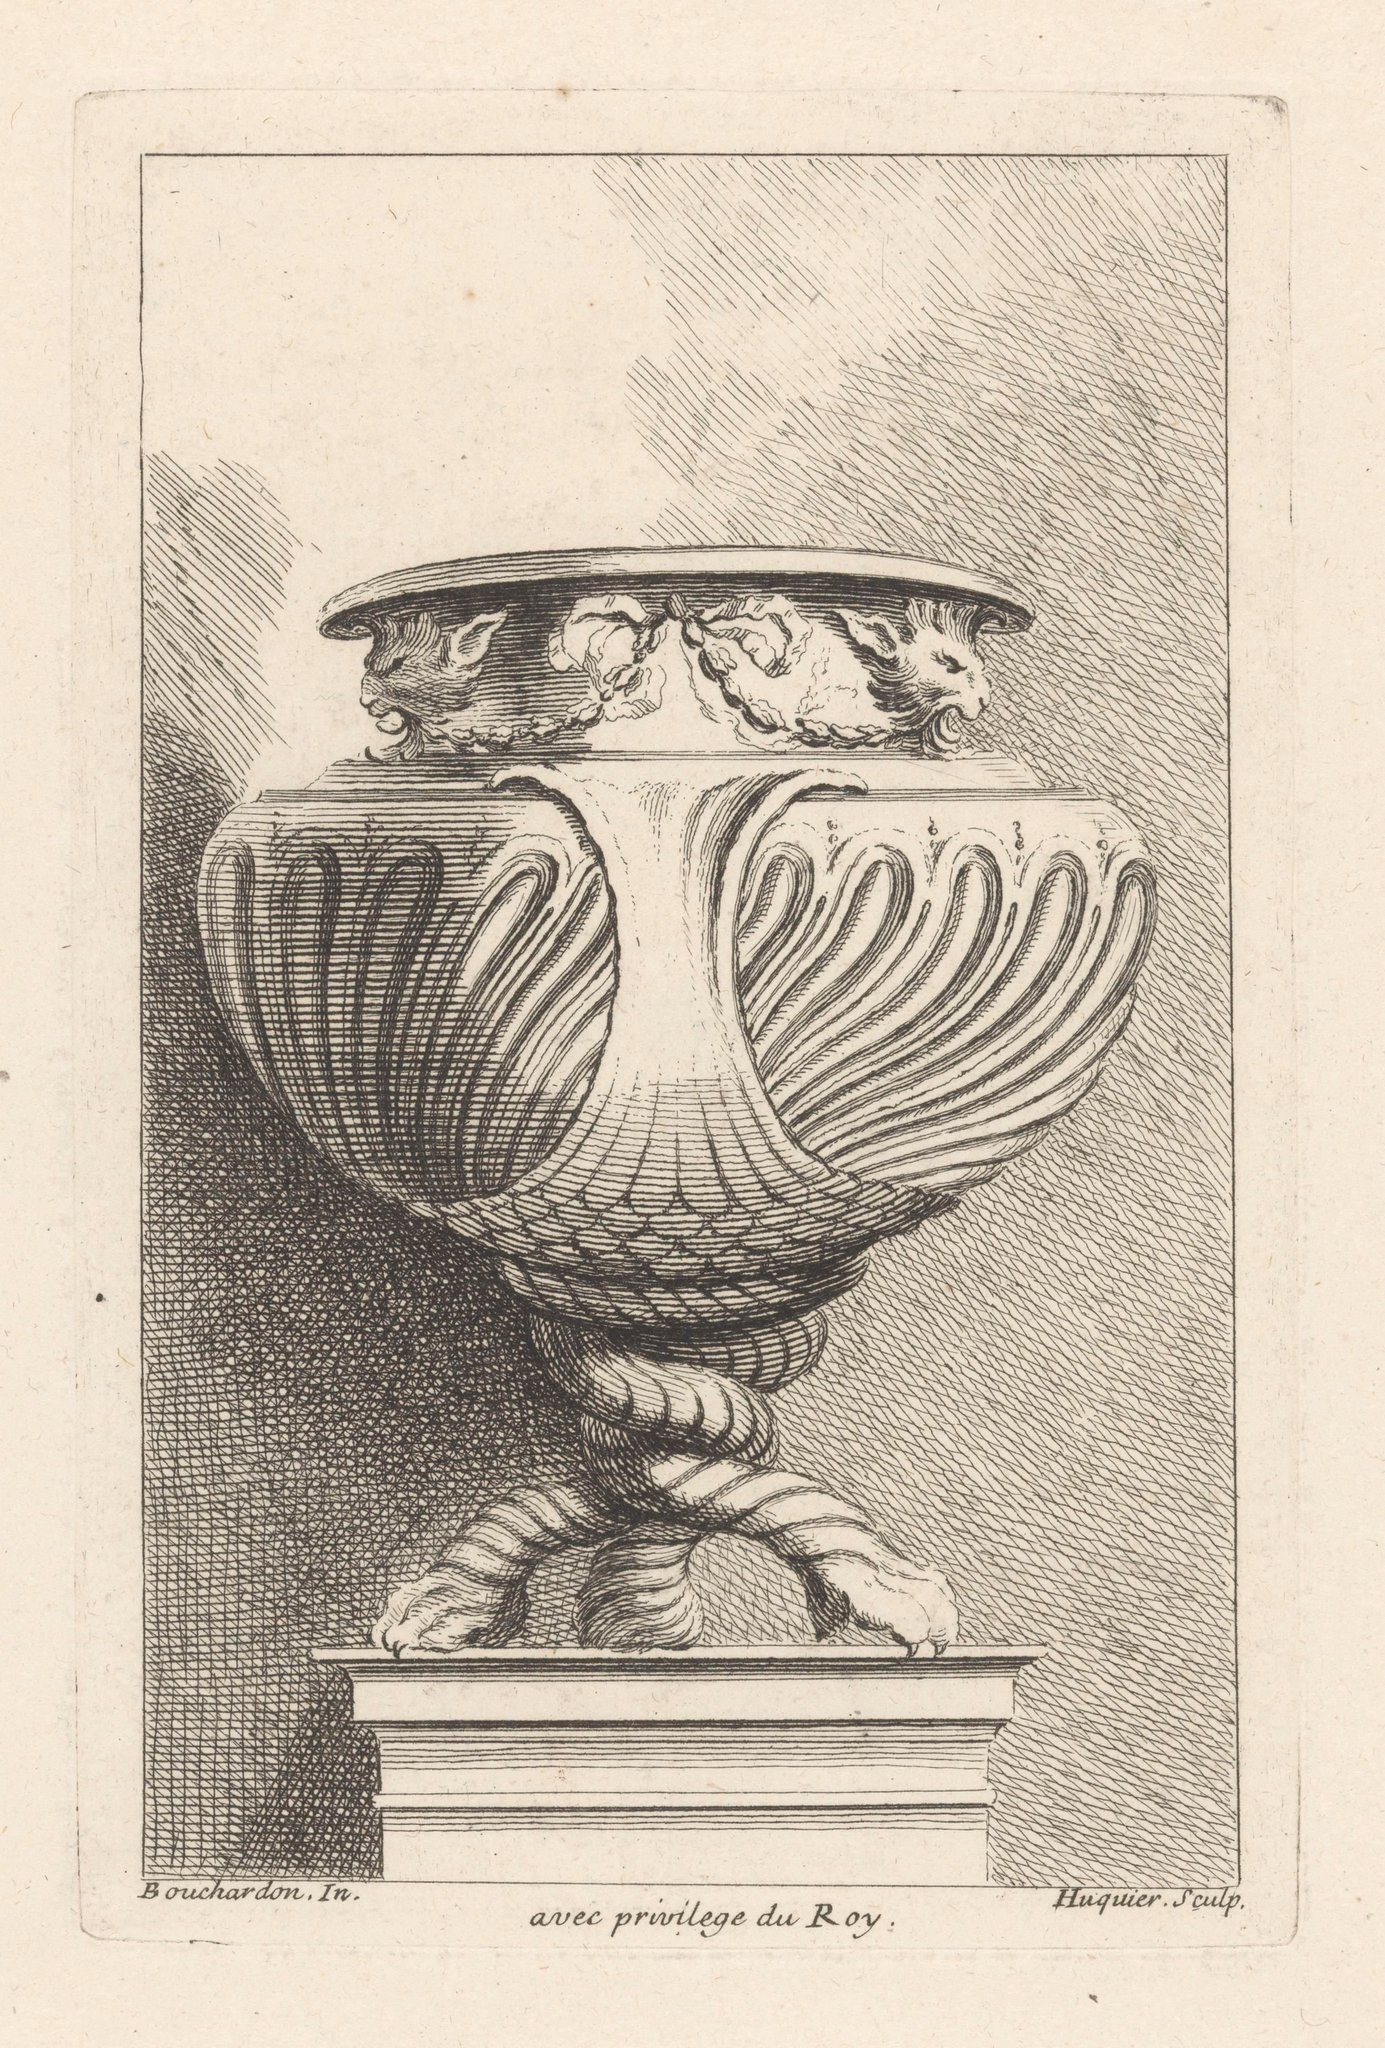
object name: ornament print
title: Premier livre de vases (...)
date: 1729-1737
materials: paper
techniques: etching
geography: paris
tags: vase ~ ornament, satyr(s) (in general), beasts of prey, predatory animals: lion, ornament ~ festoon, garland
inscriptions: collector's mark: Lugt 2228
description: Een vaas op leeuwenpoten met guirlandes en saterkoppen.